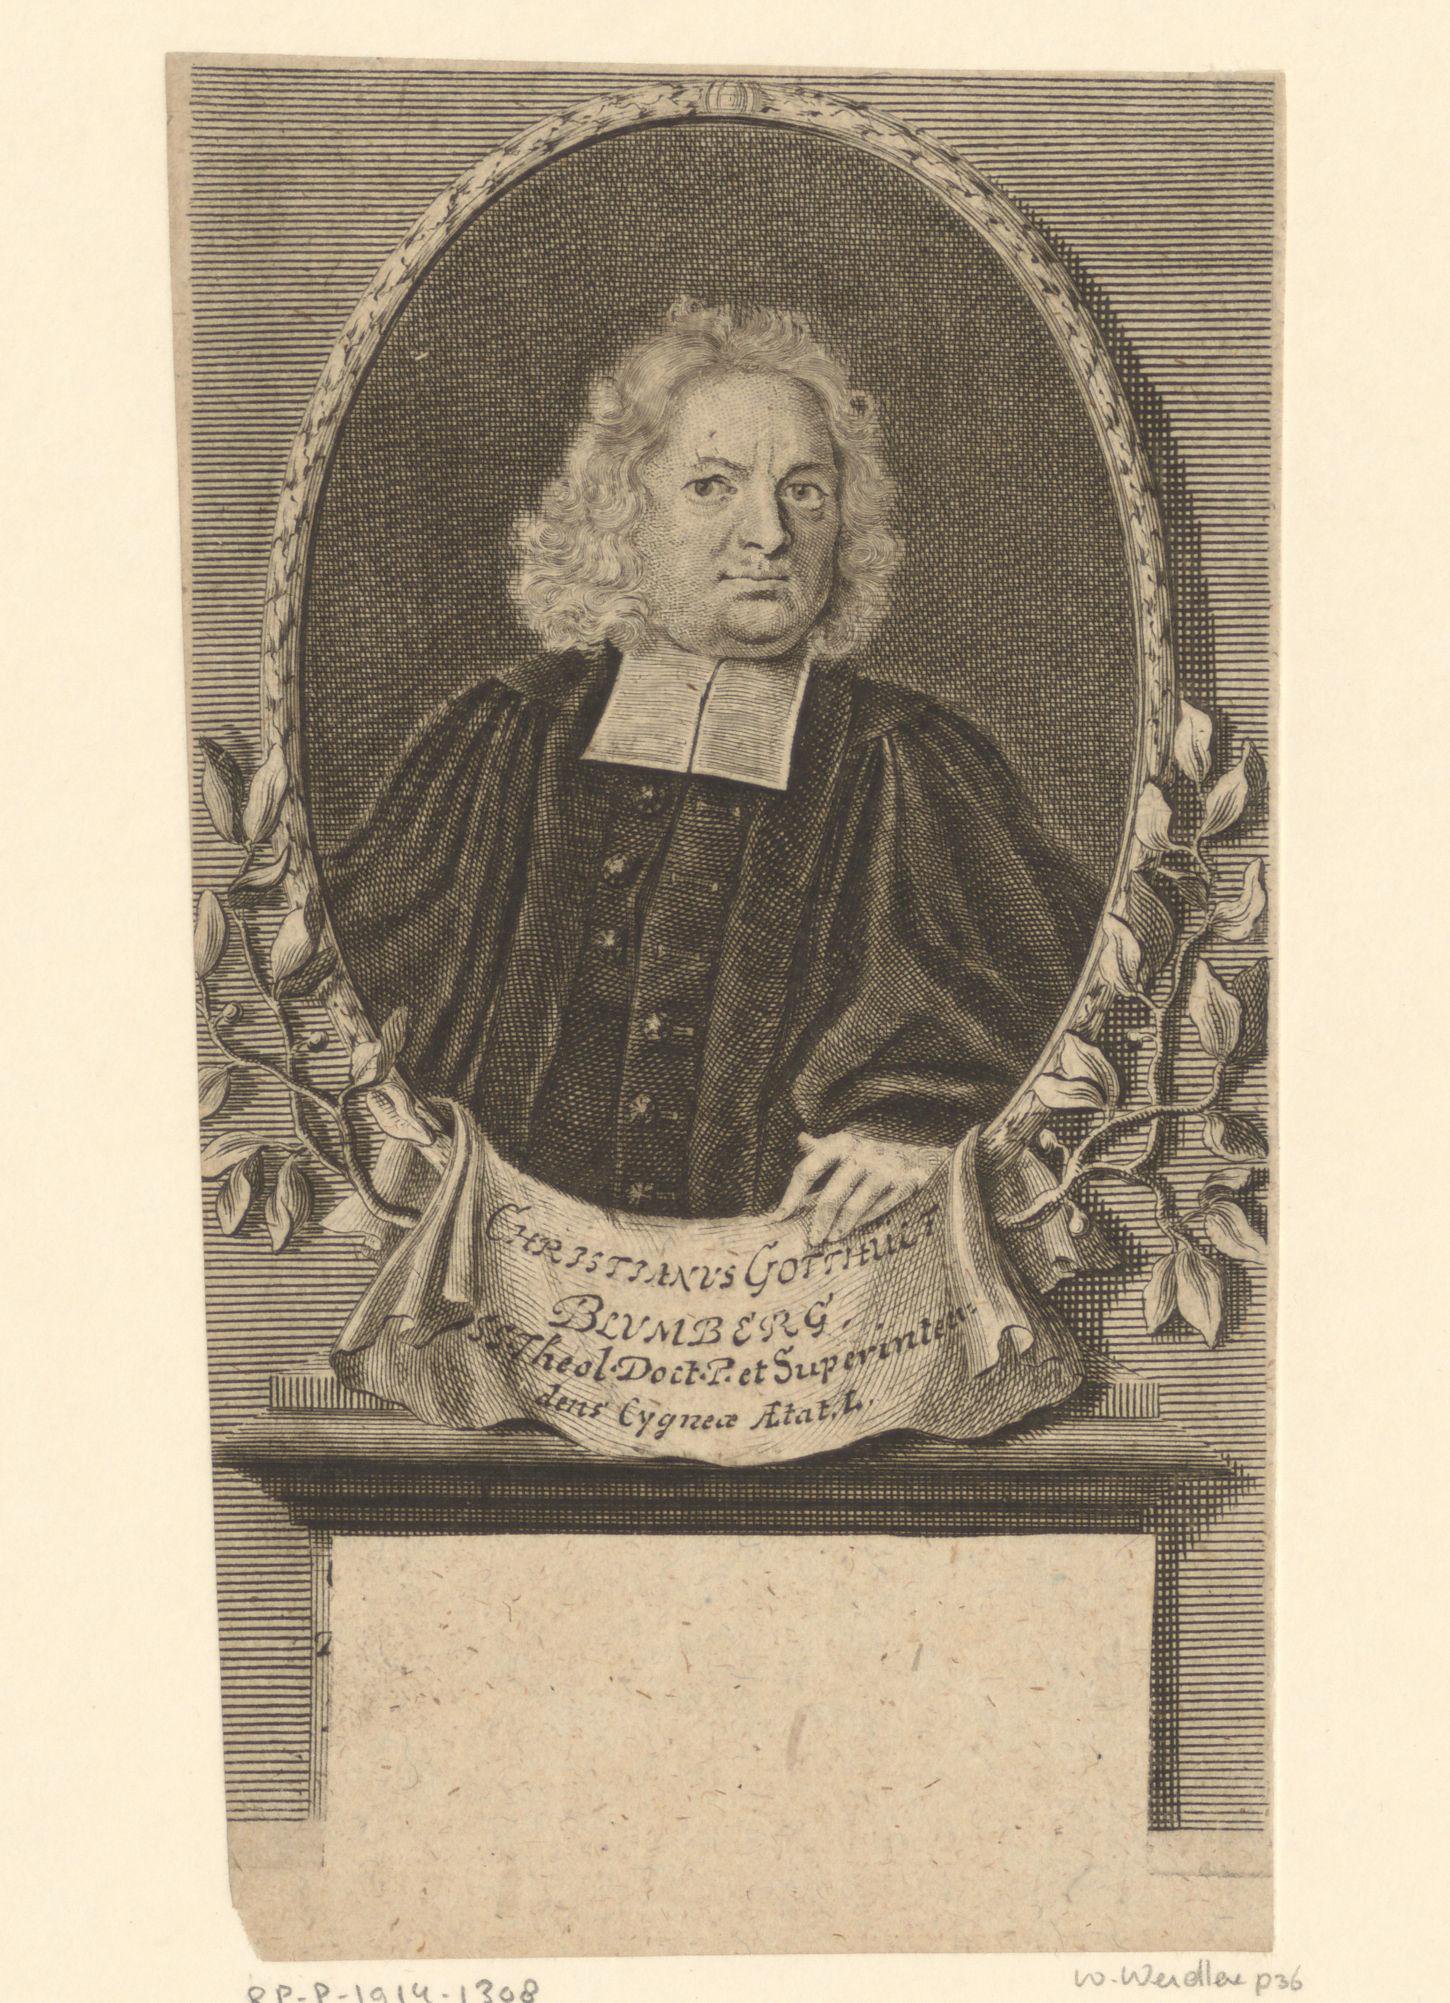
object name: print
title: Portret van Chrisitan Gotthilf Blumberg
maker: martin bernigeroth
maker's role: print maker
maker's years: 1670-1733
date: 1714-1733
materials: paper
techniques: engraving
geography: leipzig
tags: historical persons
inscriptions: collector's mark: Lugt 2228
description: Bij het drukken van de prent is een deel van de plaat afgedekt waardoor het gedicht van Johann Wilhelm Jahn (1681–1725) is weggevallen.